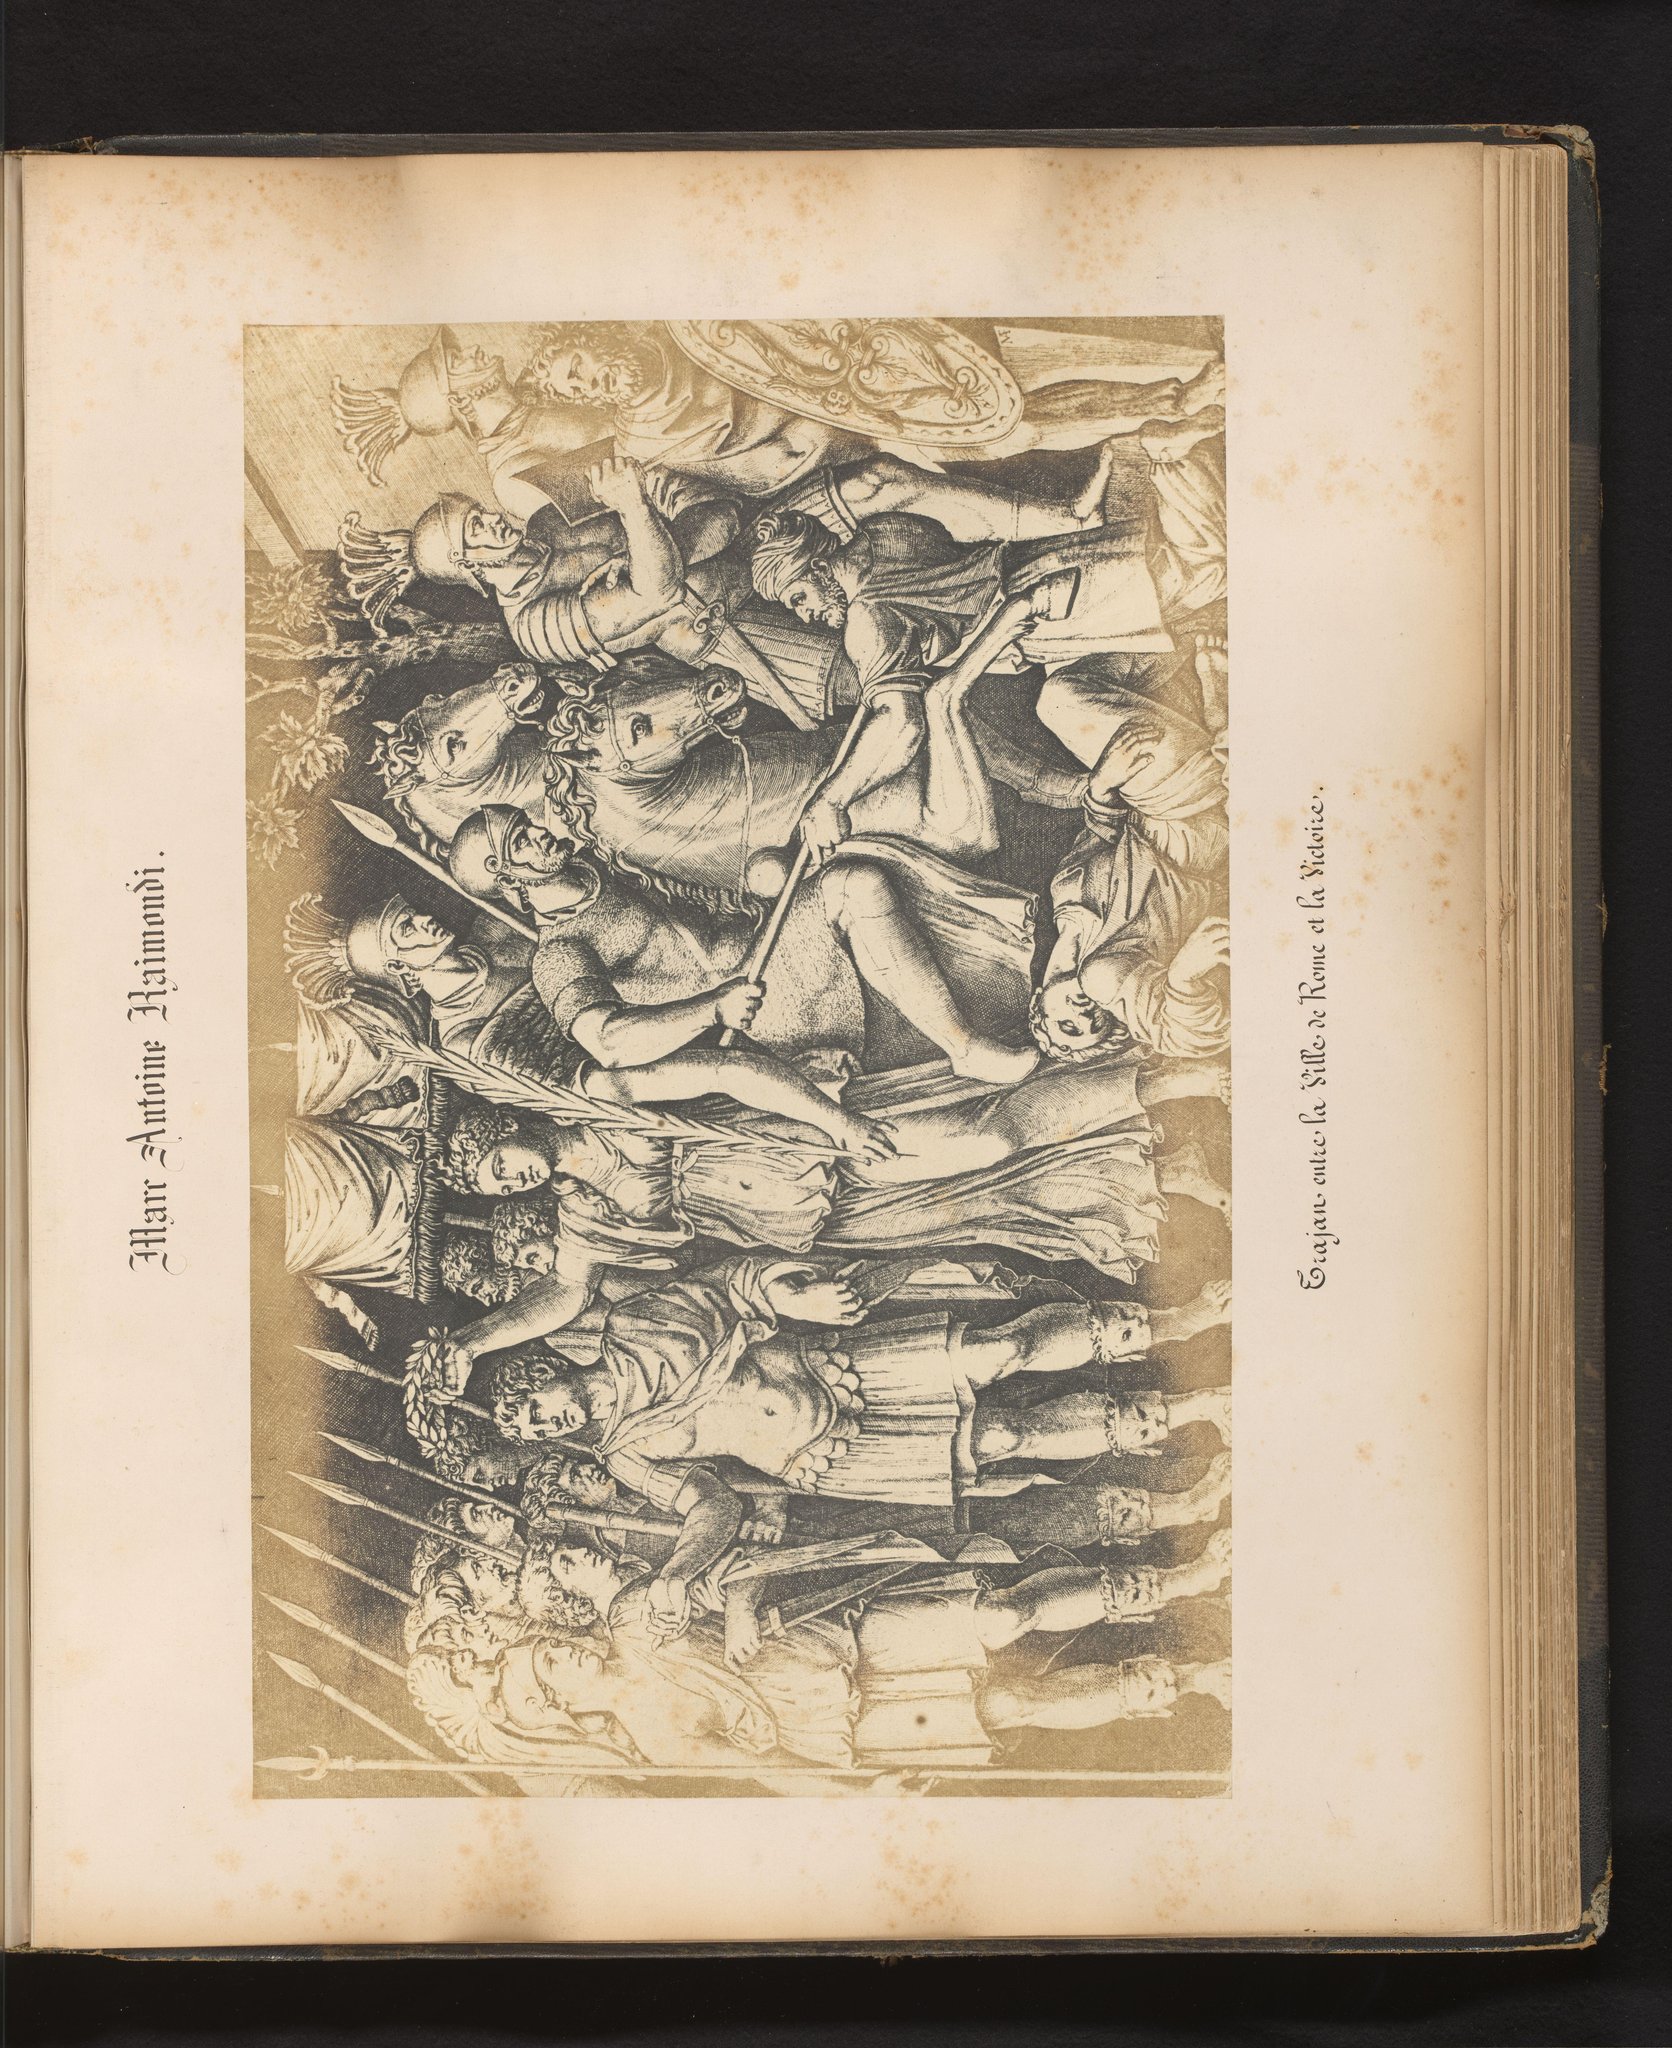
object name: page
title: Marc Antoine Raimondi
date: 1848-1853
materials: photographic support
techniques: salted paper print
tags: (story of) the emperor trajan